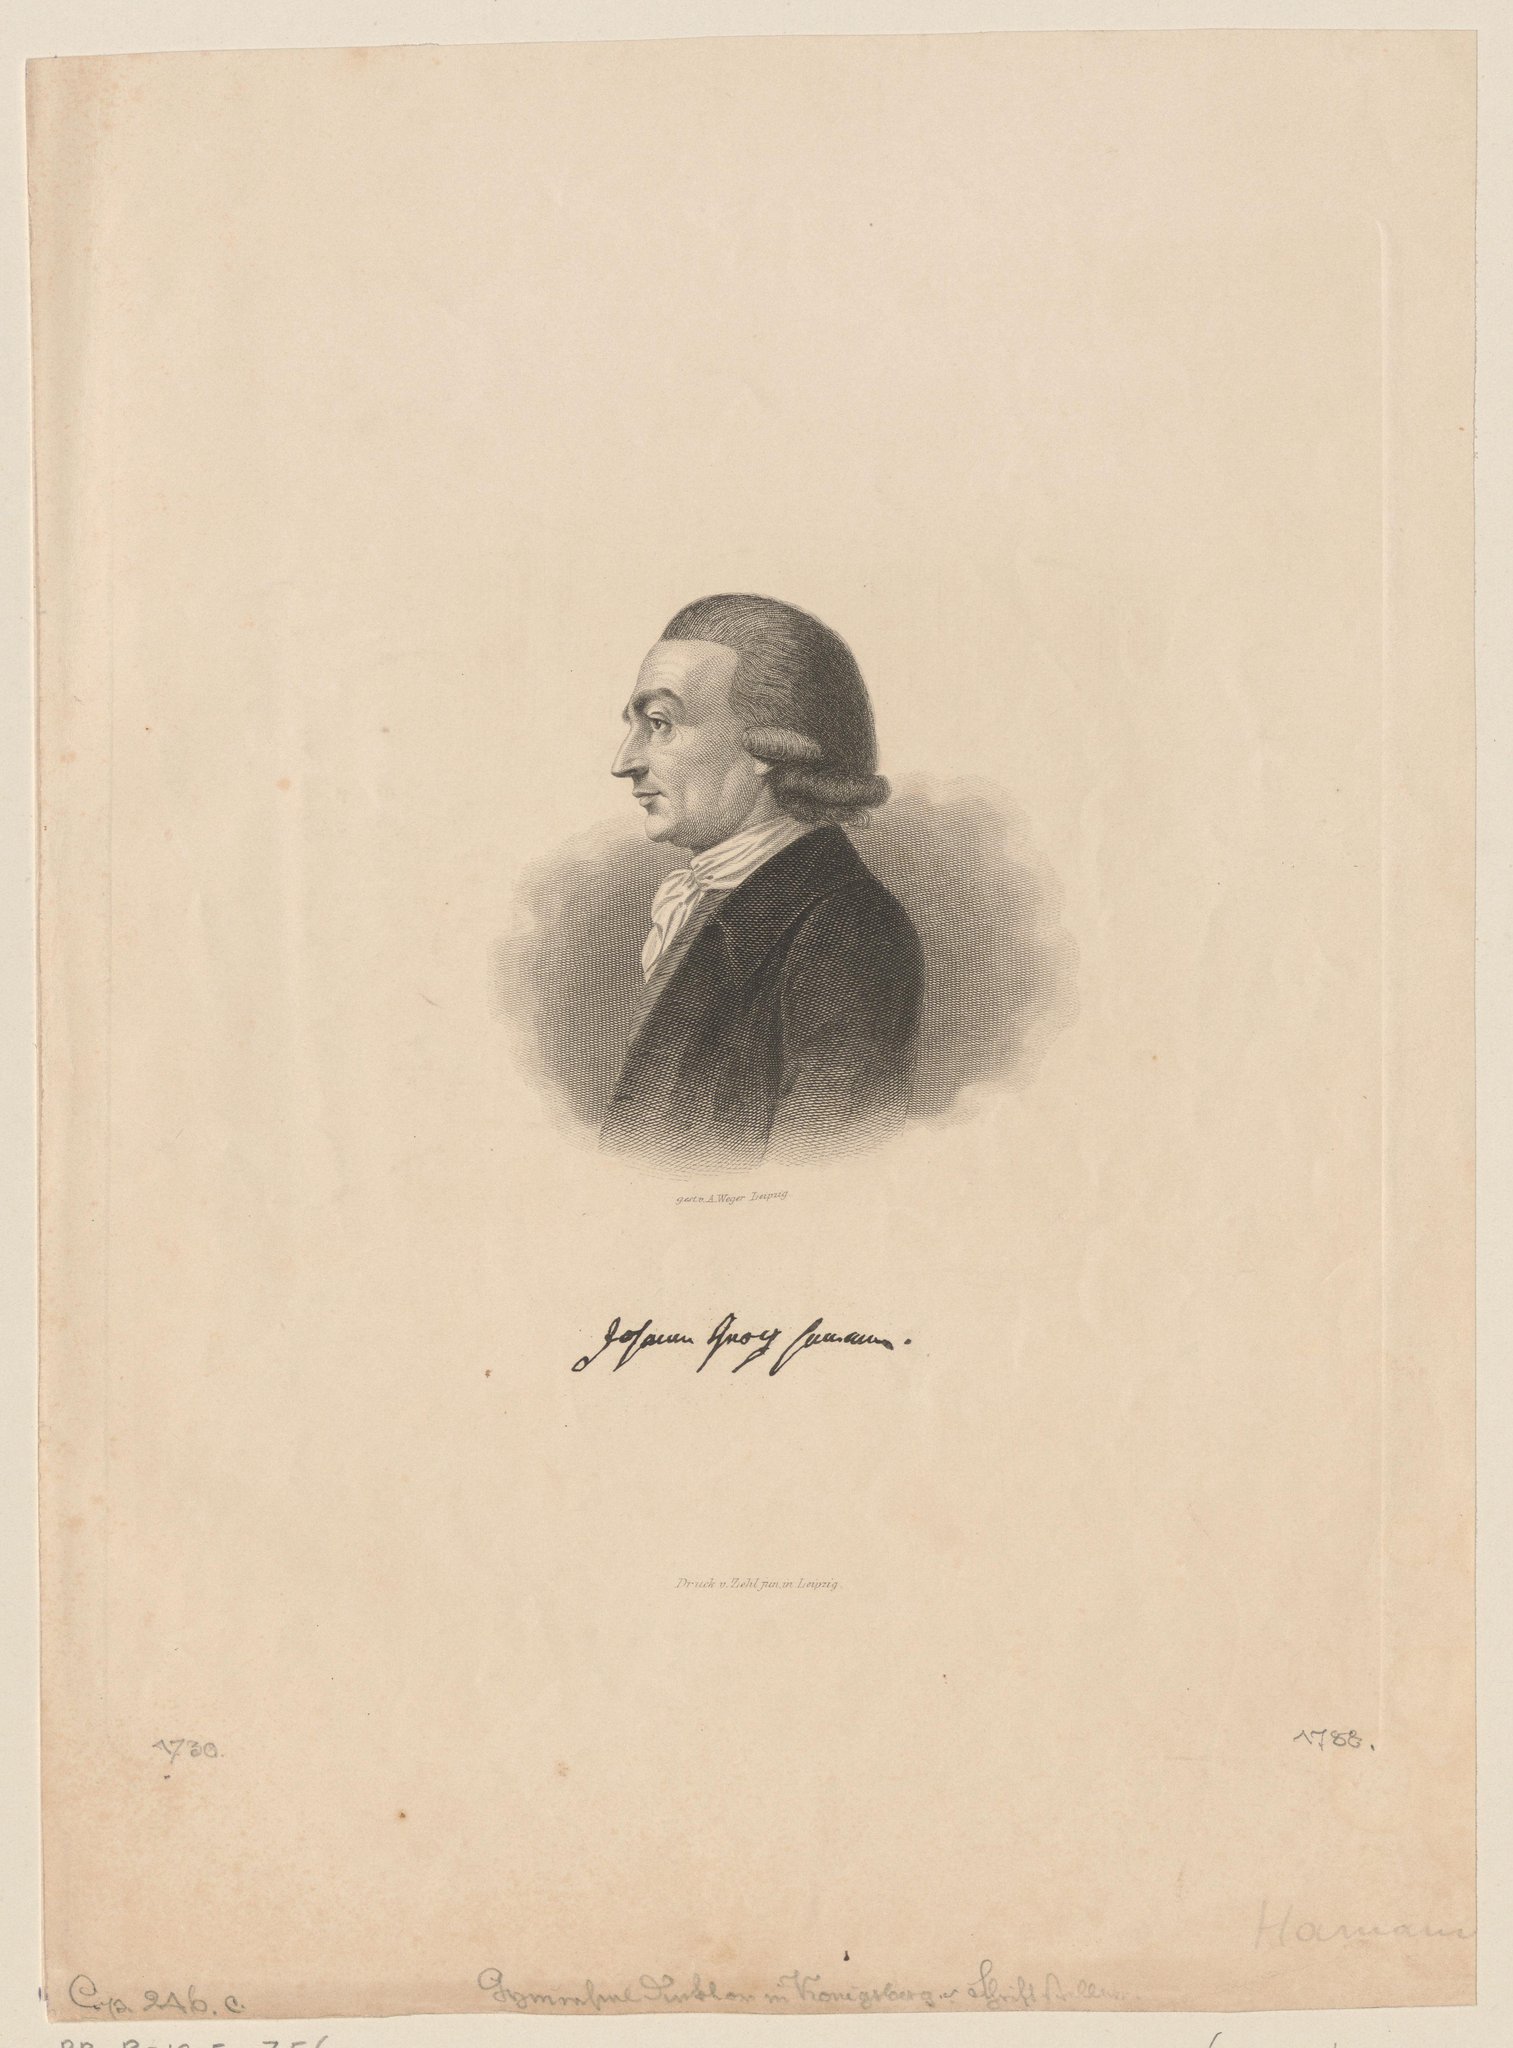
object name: print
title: Portret van Johann Georg Hamann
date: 1840-1892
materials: paper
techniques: engraving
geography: leipzig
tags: scholar, philosopher, historical persons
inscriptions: collector's mark: Lugt 2233